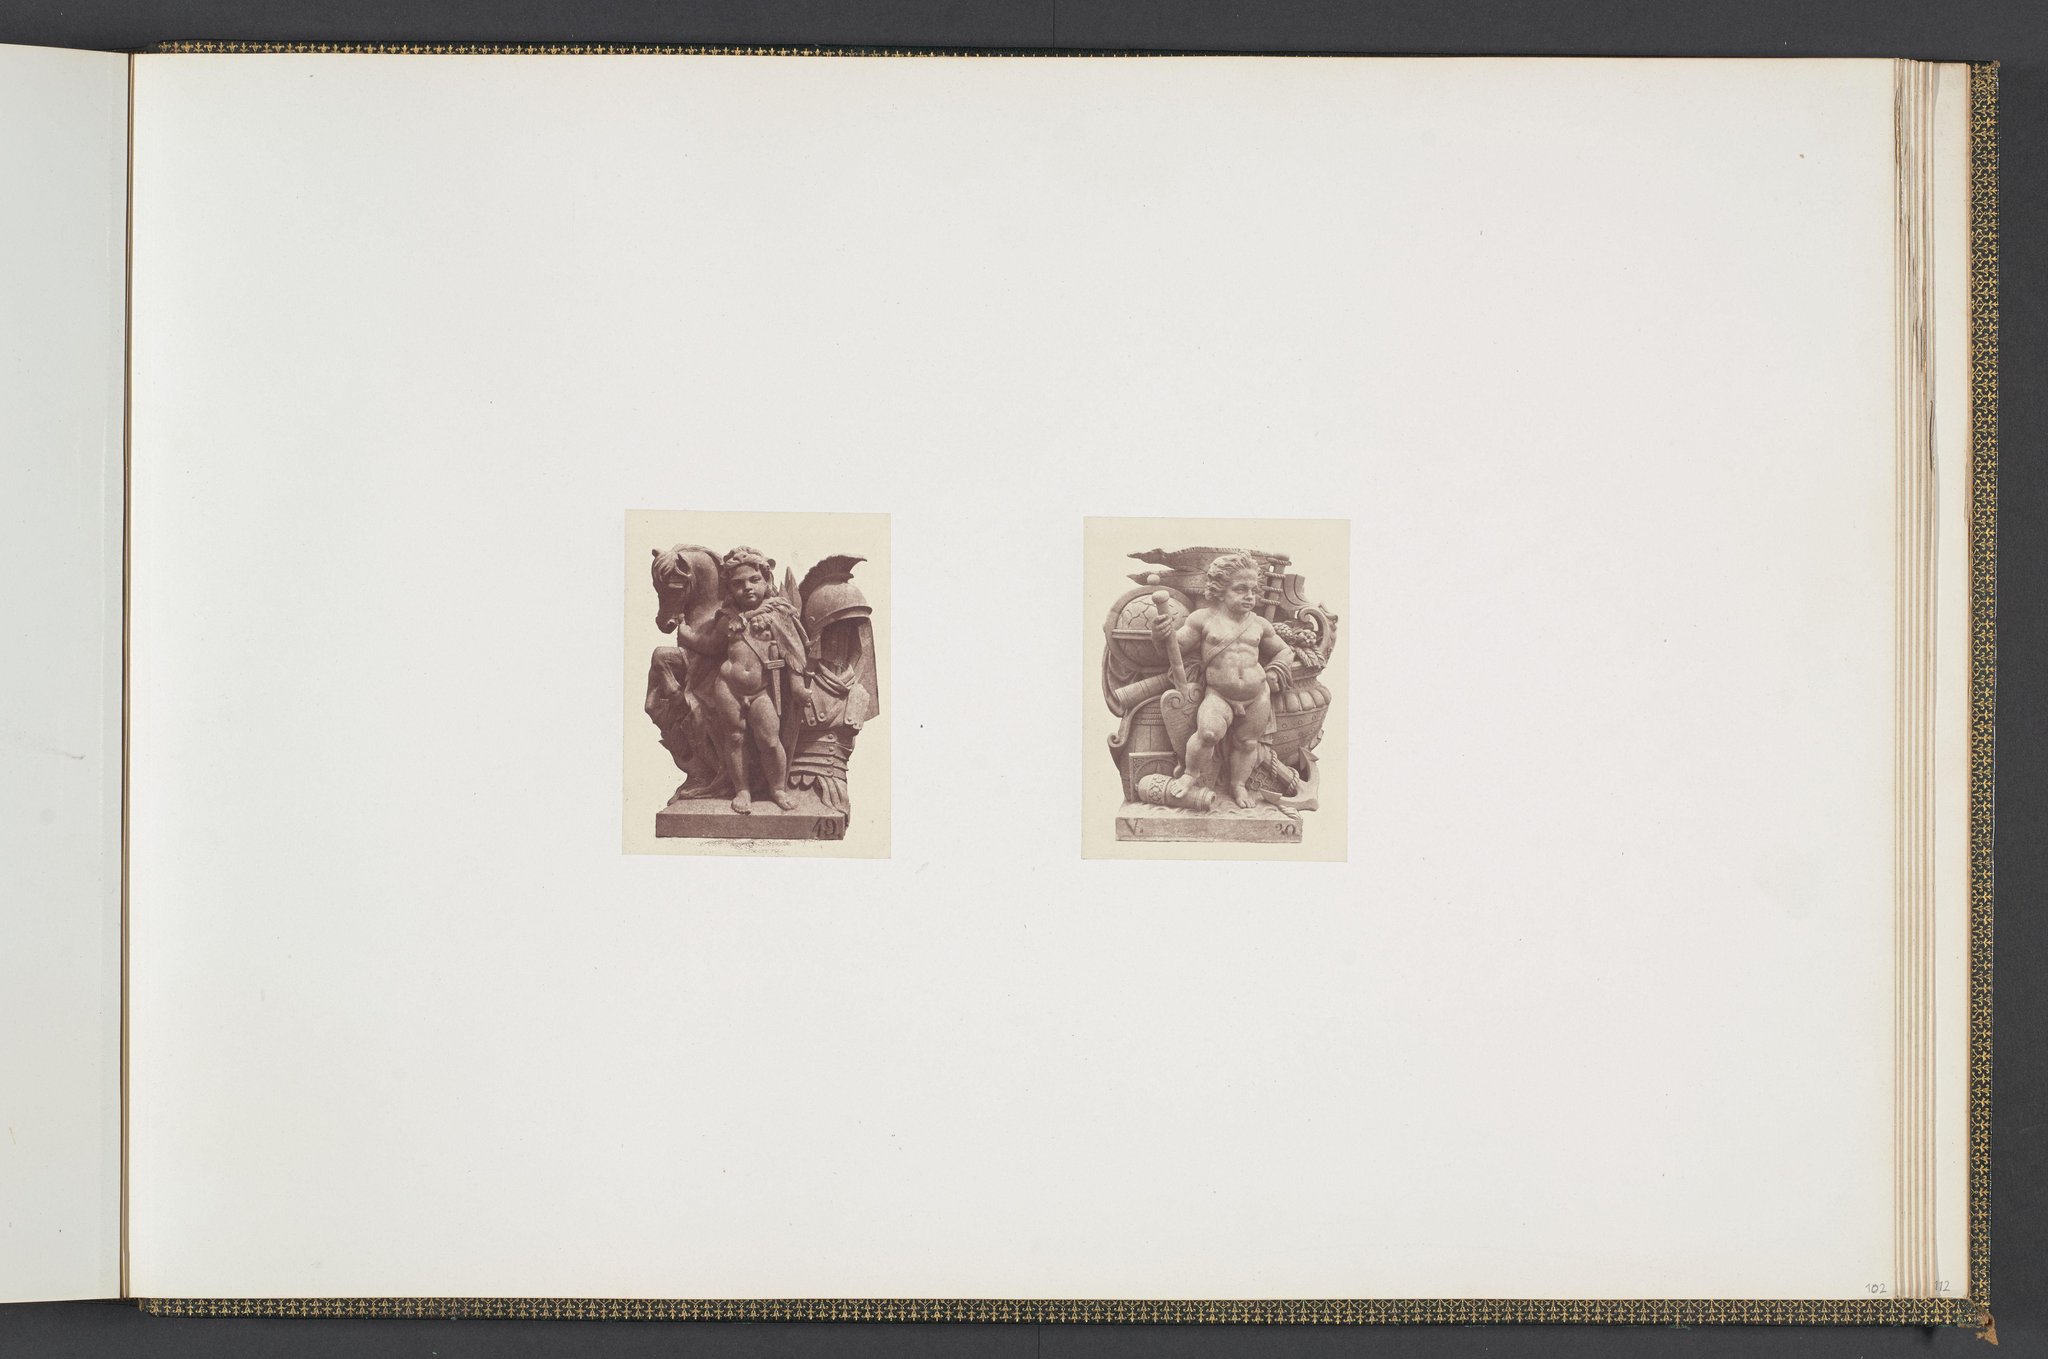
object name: album leaf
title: Gipsmodellen voor beeldhouwwerken op het Palais du Louvre: links "Les Combats" door Edme Sornet en rechts "La Navigation" door Pierre Travaux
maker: édouard denis baldus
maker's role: fotograaf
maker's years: 1813-1889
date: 1855-1857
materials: paper, photographic support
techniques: salted paper print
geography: paris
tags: piece of sculpture, reproduction of a piece of sculpture, permanent exhibition, museum, paris, tuileries palace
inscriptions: number: ‘49 en V30’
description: Onderdeel van Réunion des Tuileries au Louvre 1852-1857, album 2.